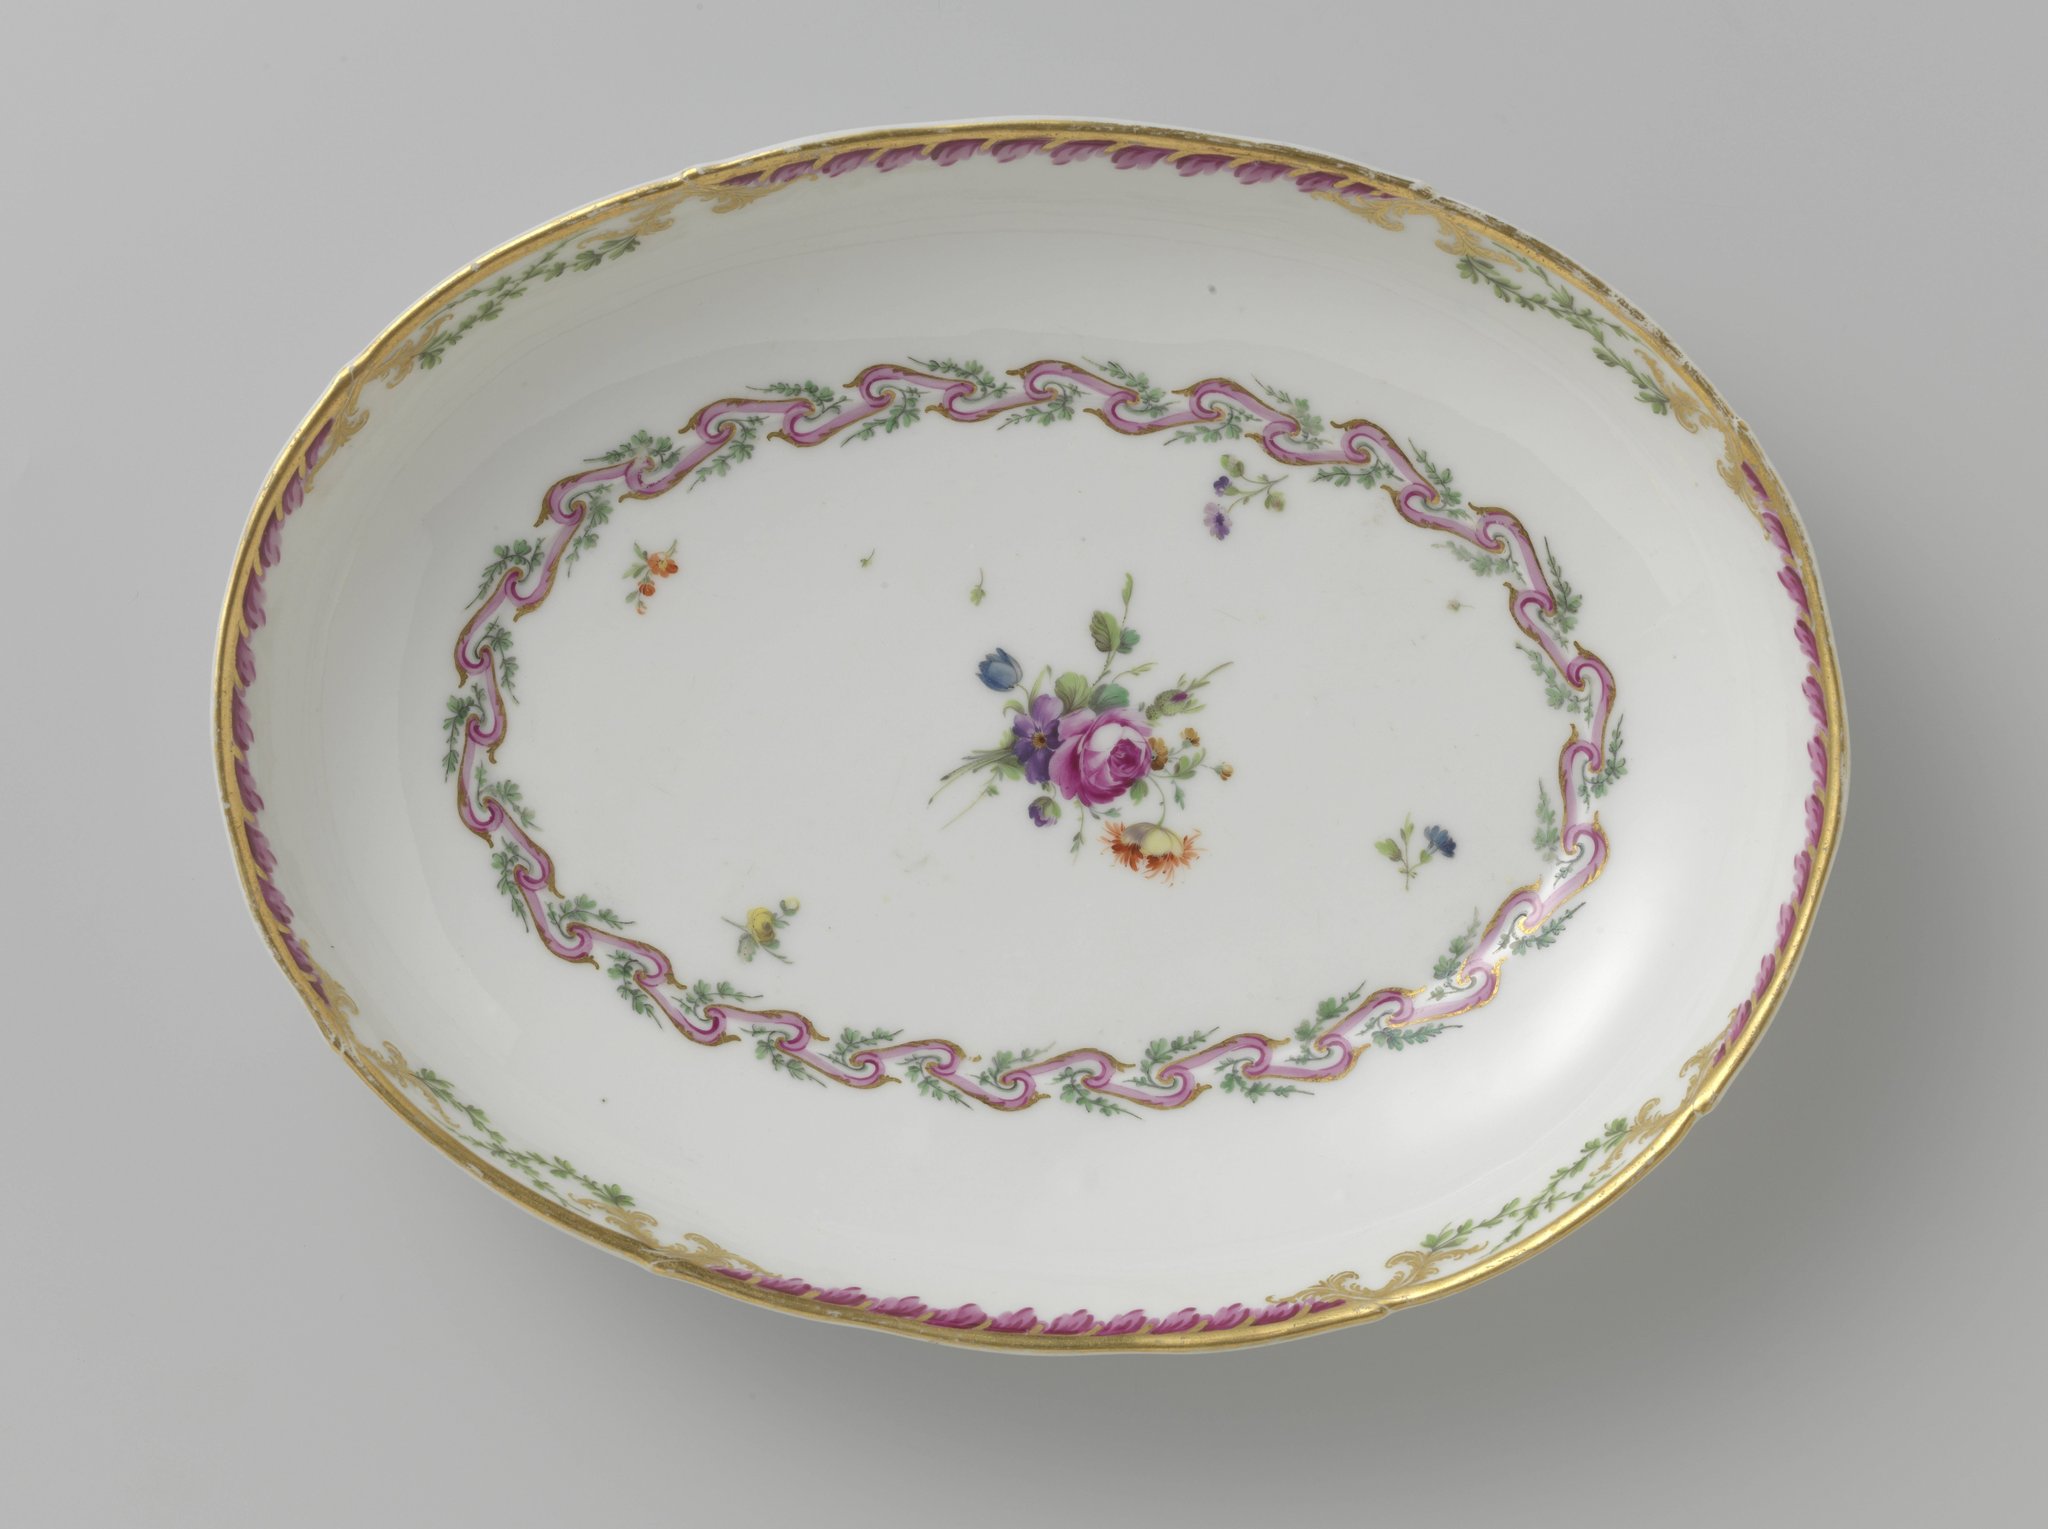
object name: dish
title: Schaal, diep en ovaal van vorm,behorend bij een servies met geslingerd lintmotief met bladertakken, bloemboeketten en gestrooide bloemtakken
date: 1780-1820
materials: porcelain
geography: loosdrecht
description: Schaal, diep en ovaal van vorm, behorend bij een servies van porselein, versierd met een geslingerd lintmotief in paars en goud met groene bladertakken, bloemboeketten en gestrooide bloemtakken. Randen lichtgegolfd met decoratie in goud met paars bladmotief waartussen groen gekruist bladmotief. Gemerkt: M.O.L. en Amstel.